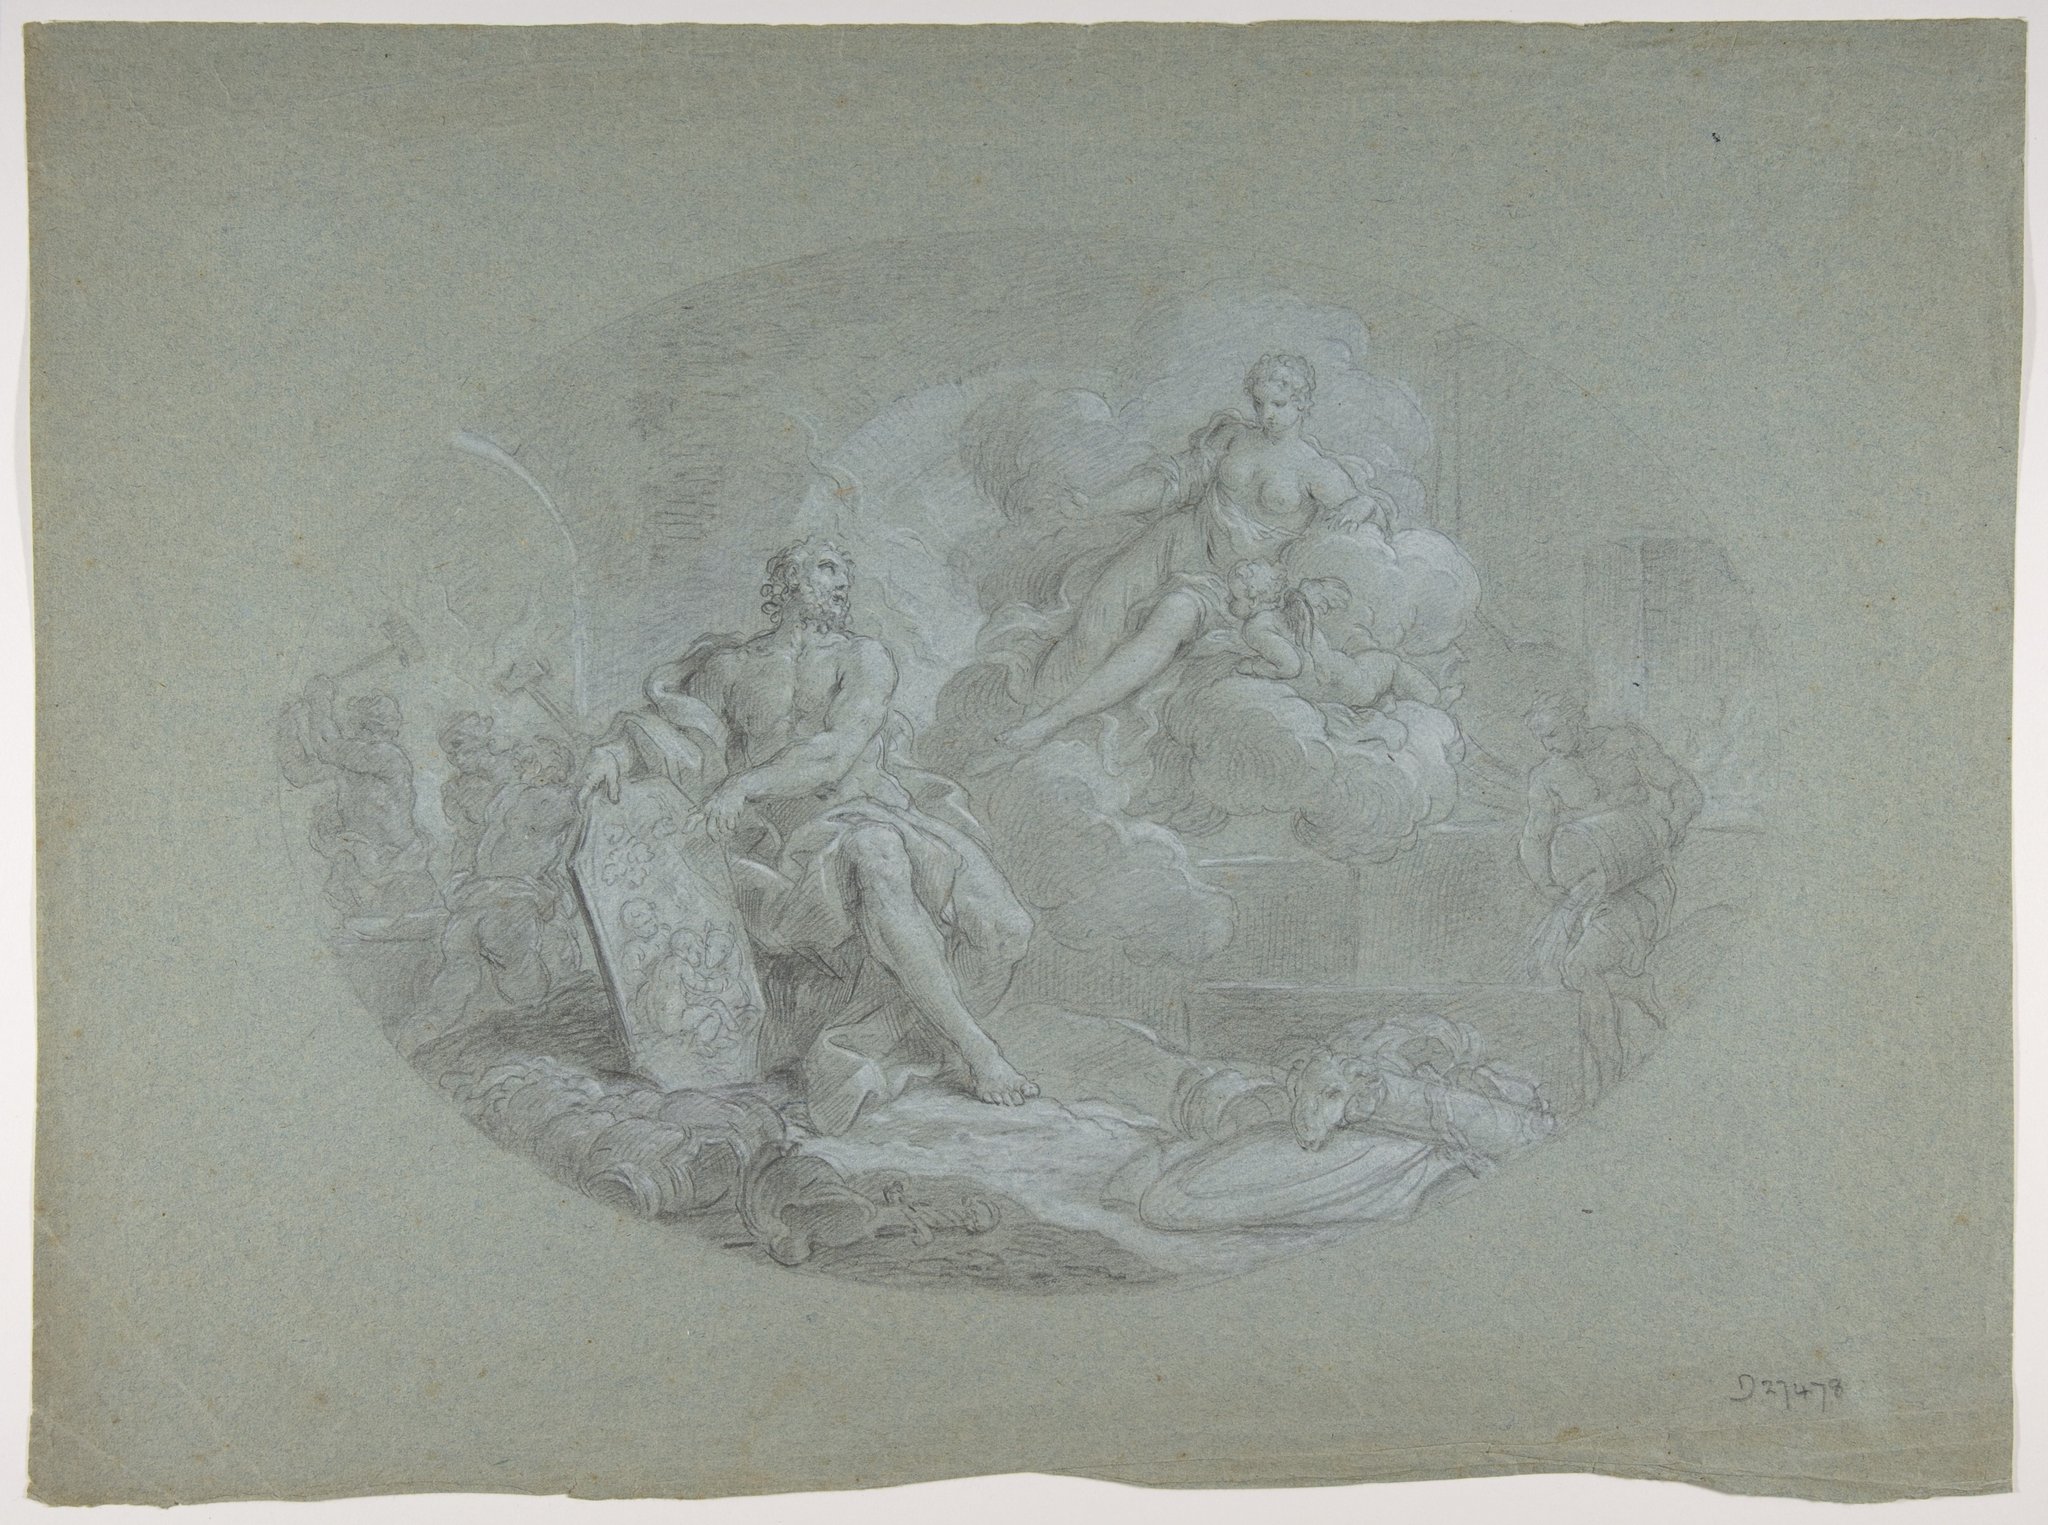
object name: drawing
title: Venus in the Forge of Vulcan (Aeneid VIII: 370 ff)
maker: stefano pozzi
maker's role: artist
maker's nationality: italian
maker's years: 1699-1768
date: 1699-1768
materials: chalk, paper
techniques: highlighting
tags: animals,cupid,venus,vulcan,hammers